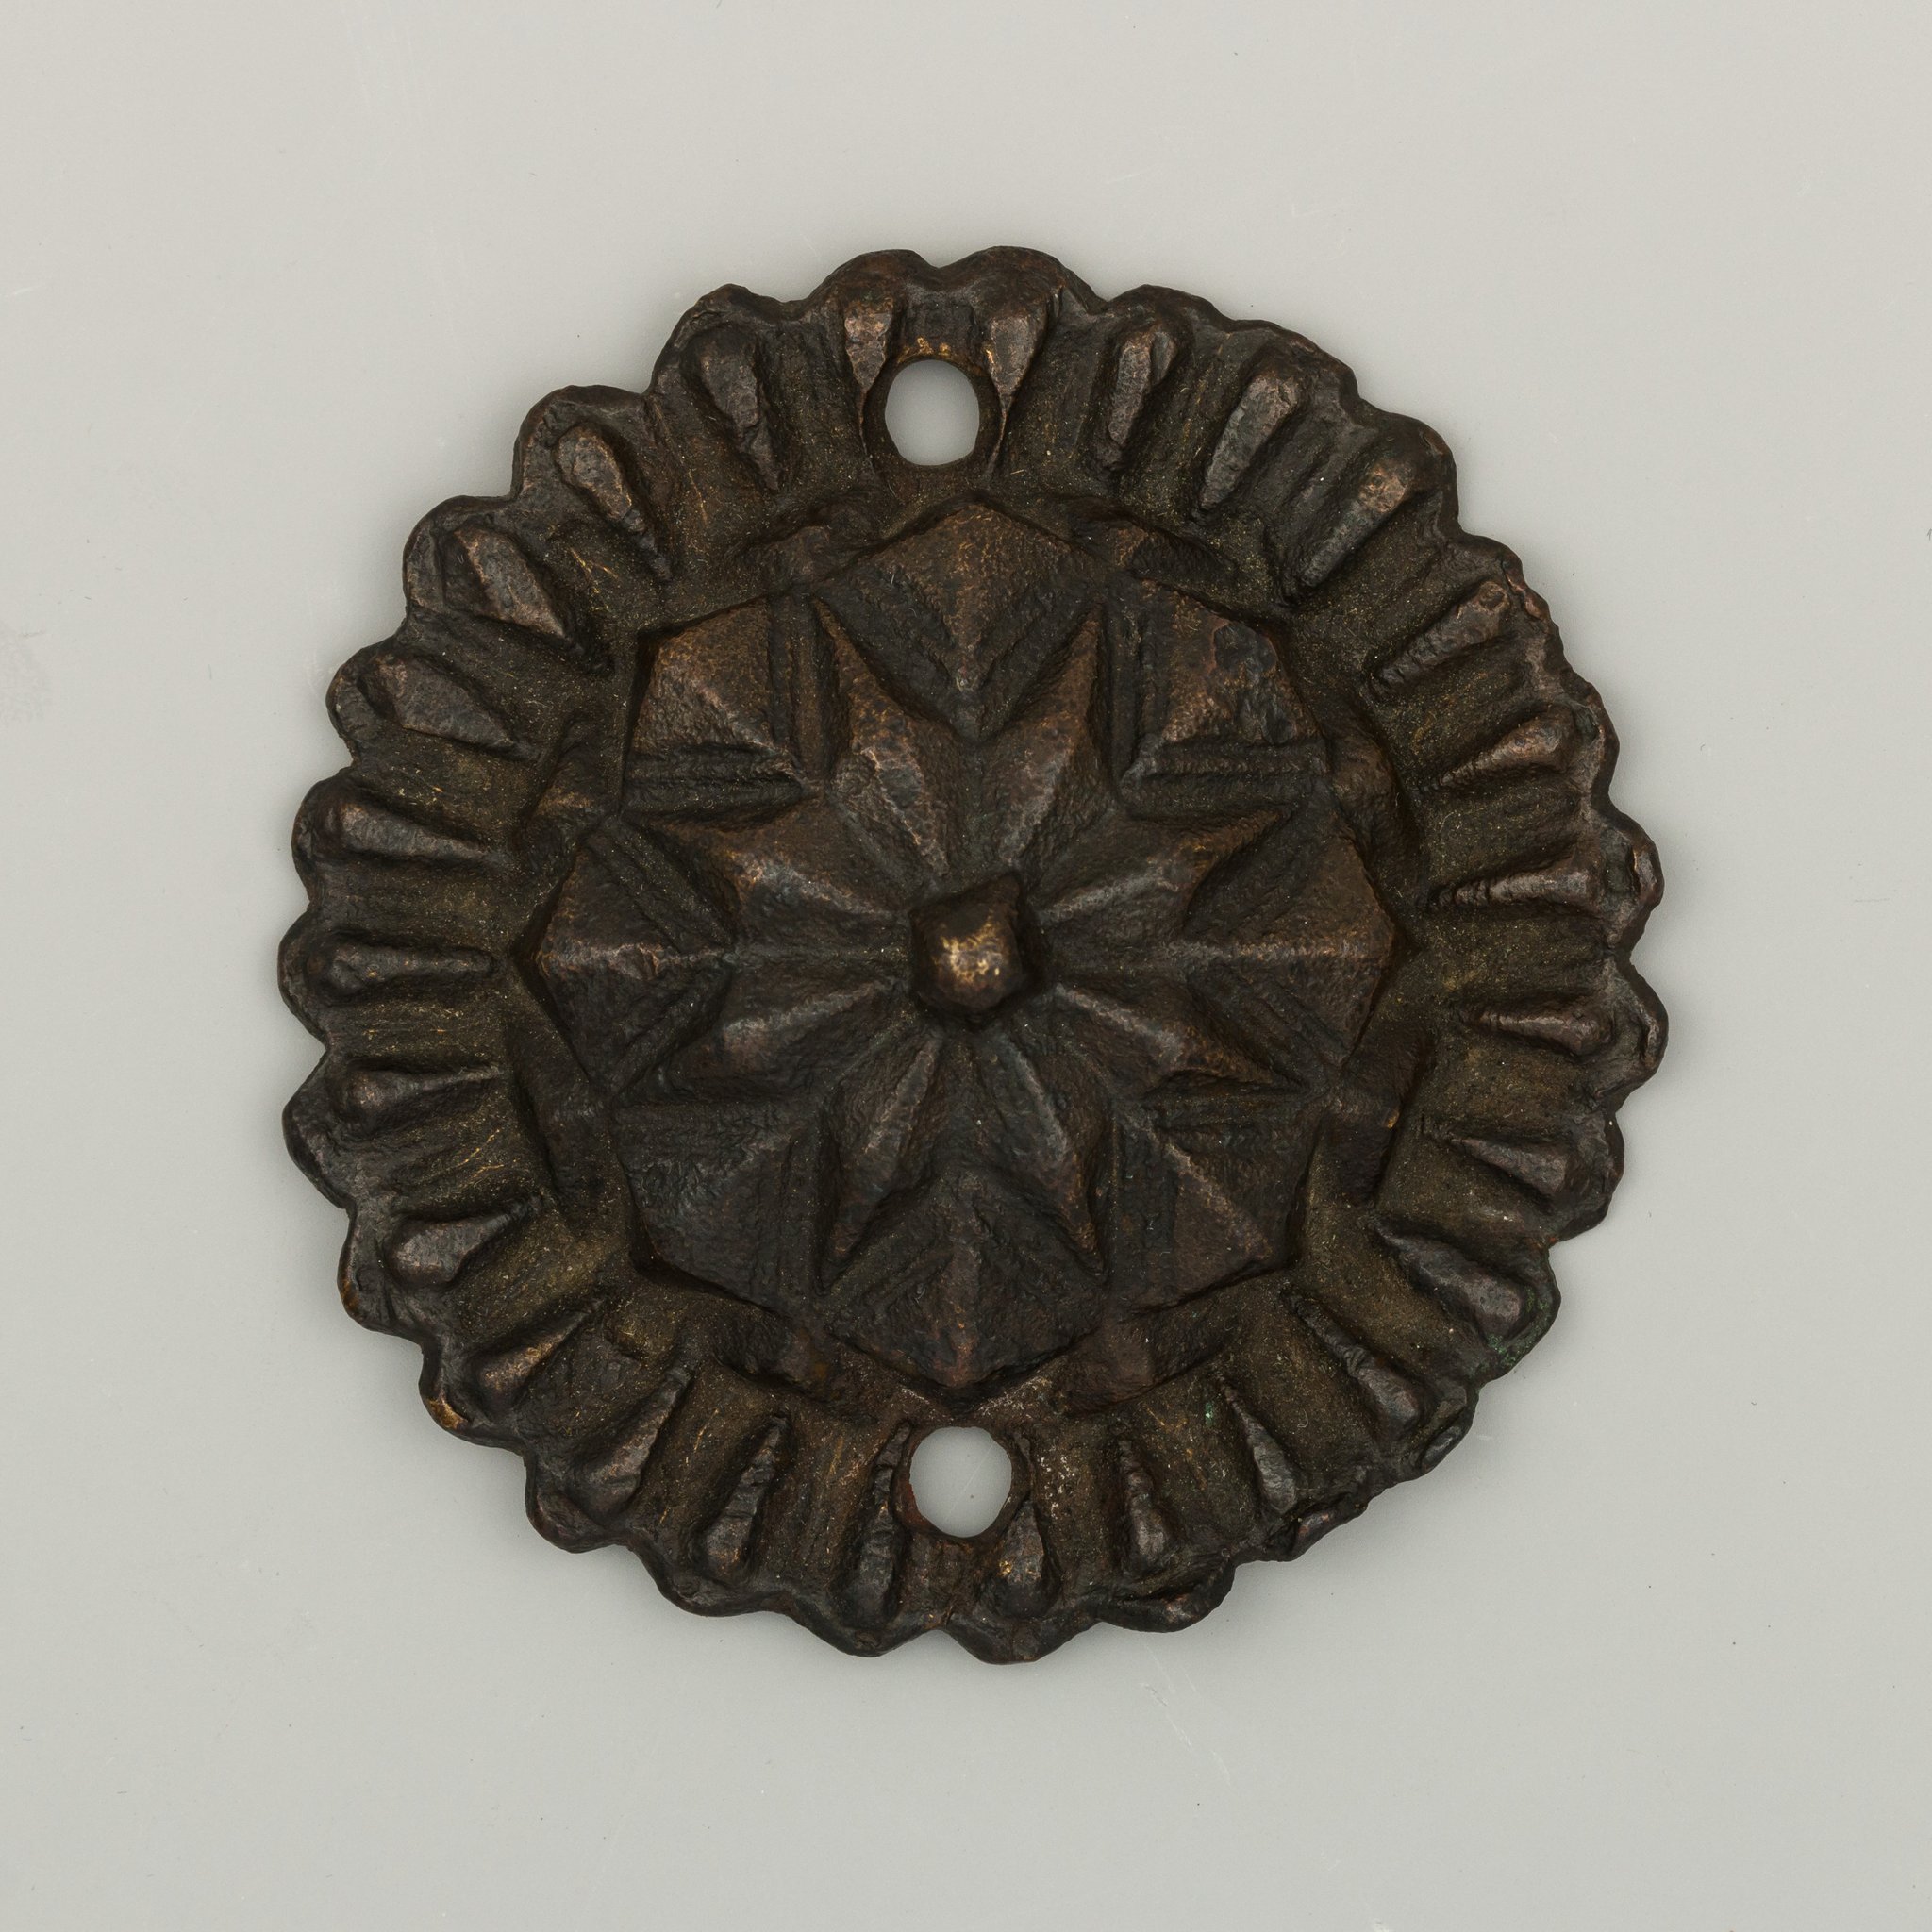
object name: bit bos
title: Bit Boss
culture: dutch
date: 1601-1650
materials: copper alloy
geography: netherlands